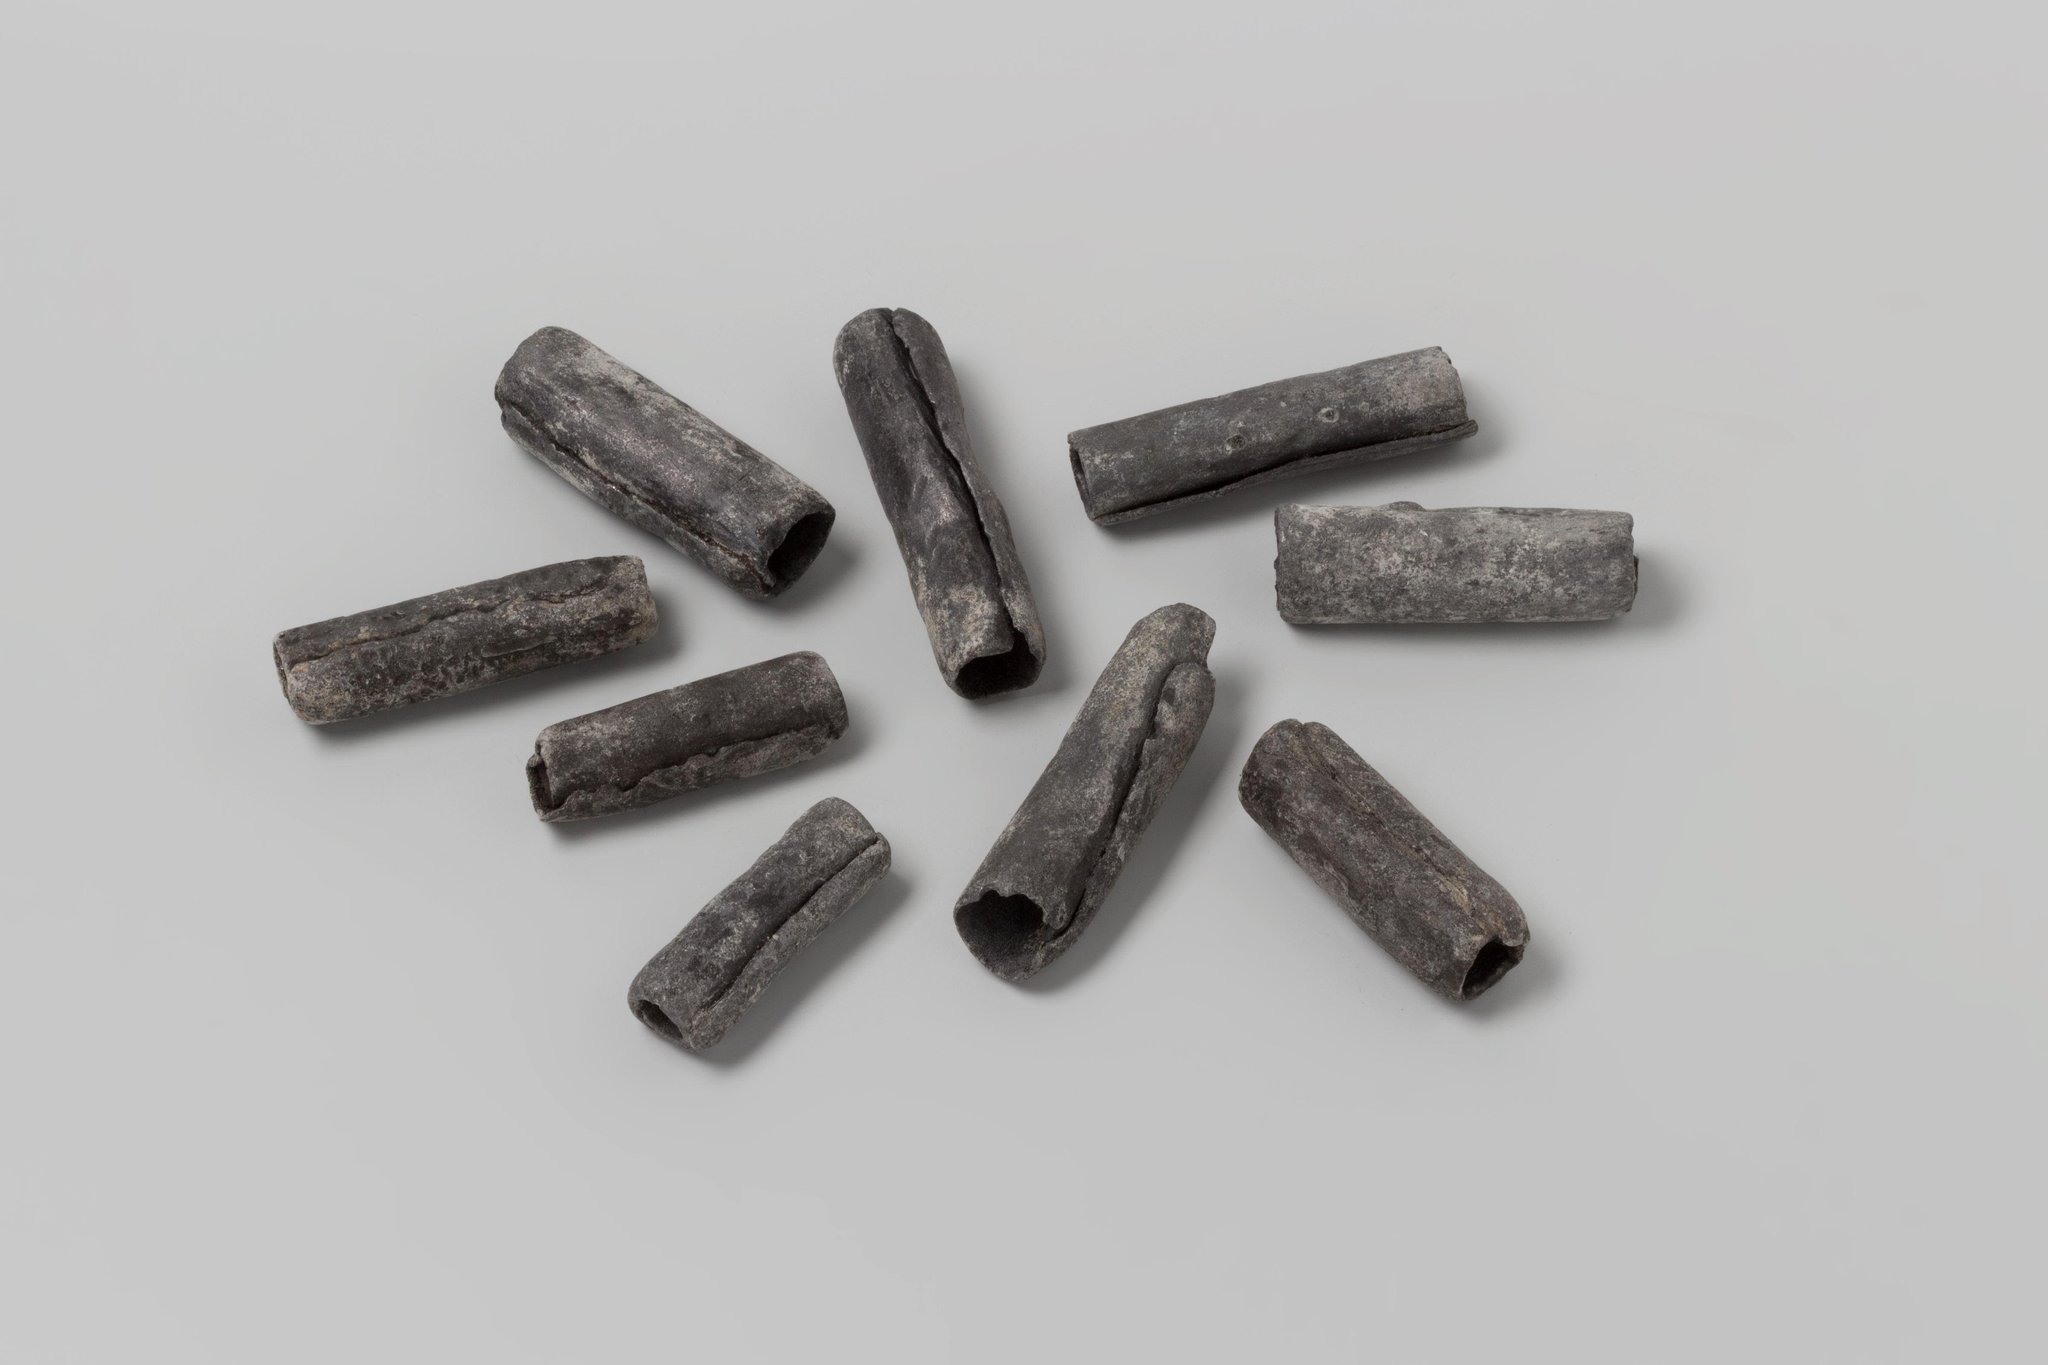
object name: lead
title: Loden rol uit het wrak van de Oost-Indiëvaarder 't Vliegend Hart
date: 1700-1735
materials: lead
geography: middelburg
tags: 't vliegend hart (schip), verenigde oostindische compagnie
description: Deze loden buisjes zijn vermoedelijk afkomstig van visnetten ofwel op TVliegend Hart zelf ofwel van vissers die hun netten aan het wrak verloren.